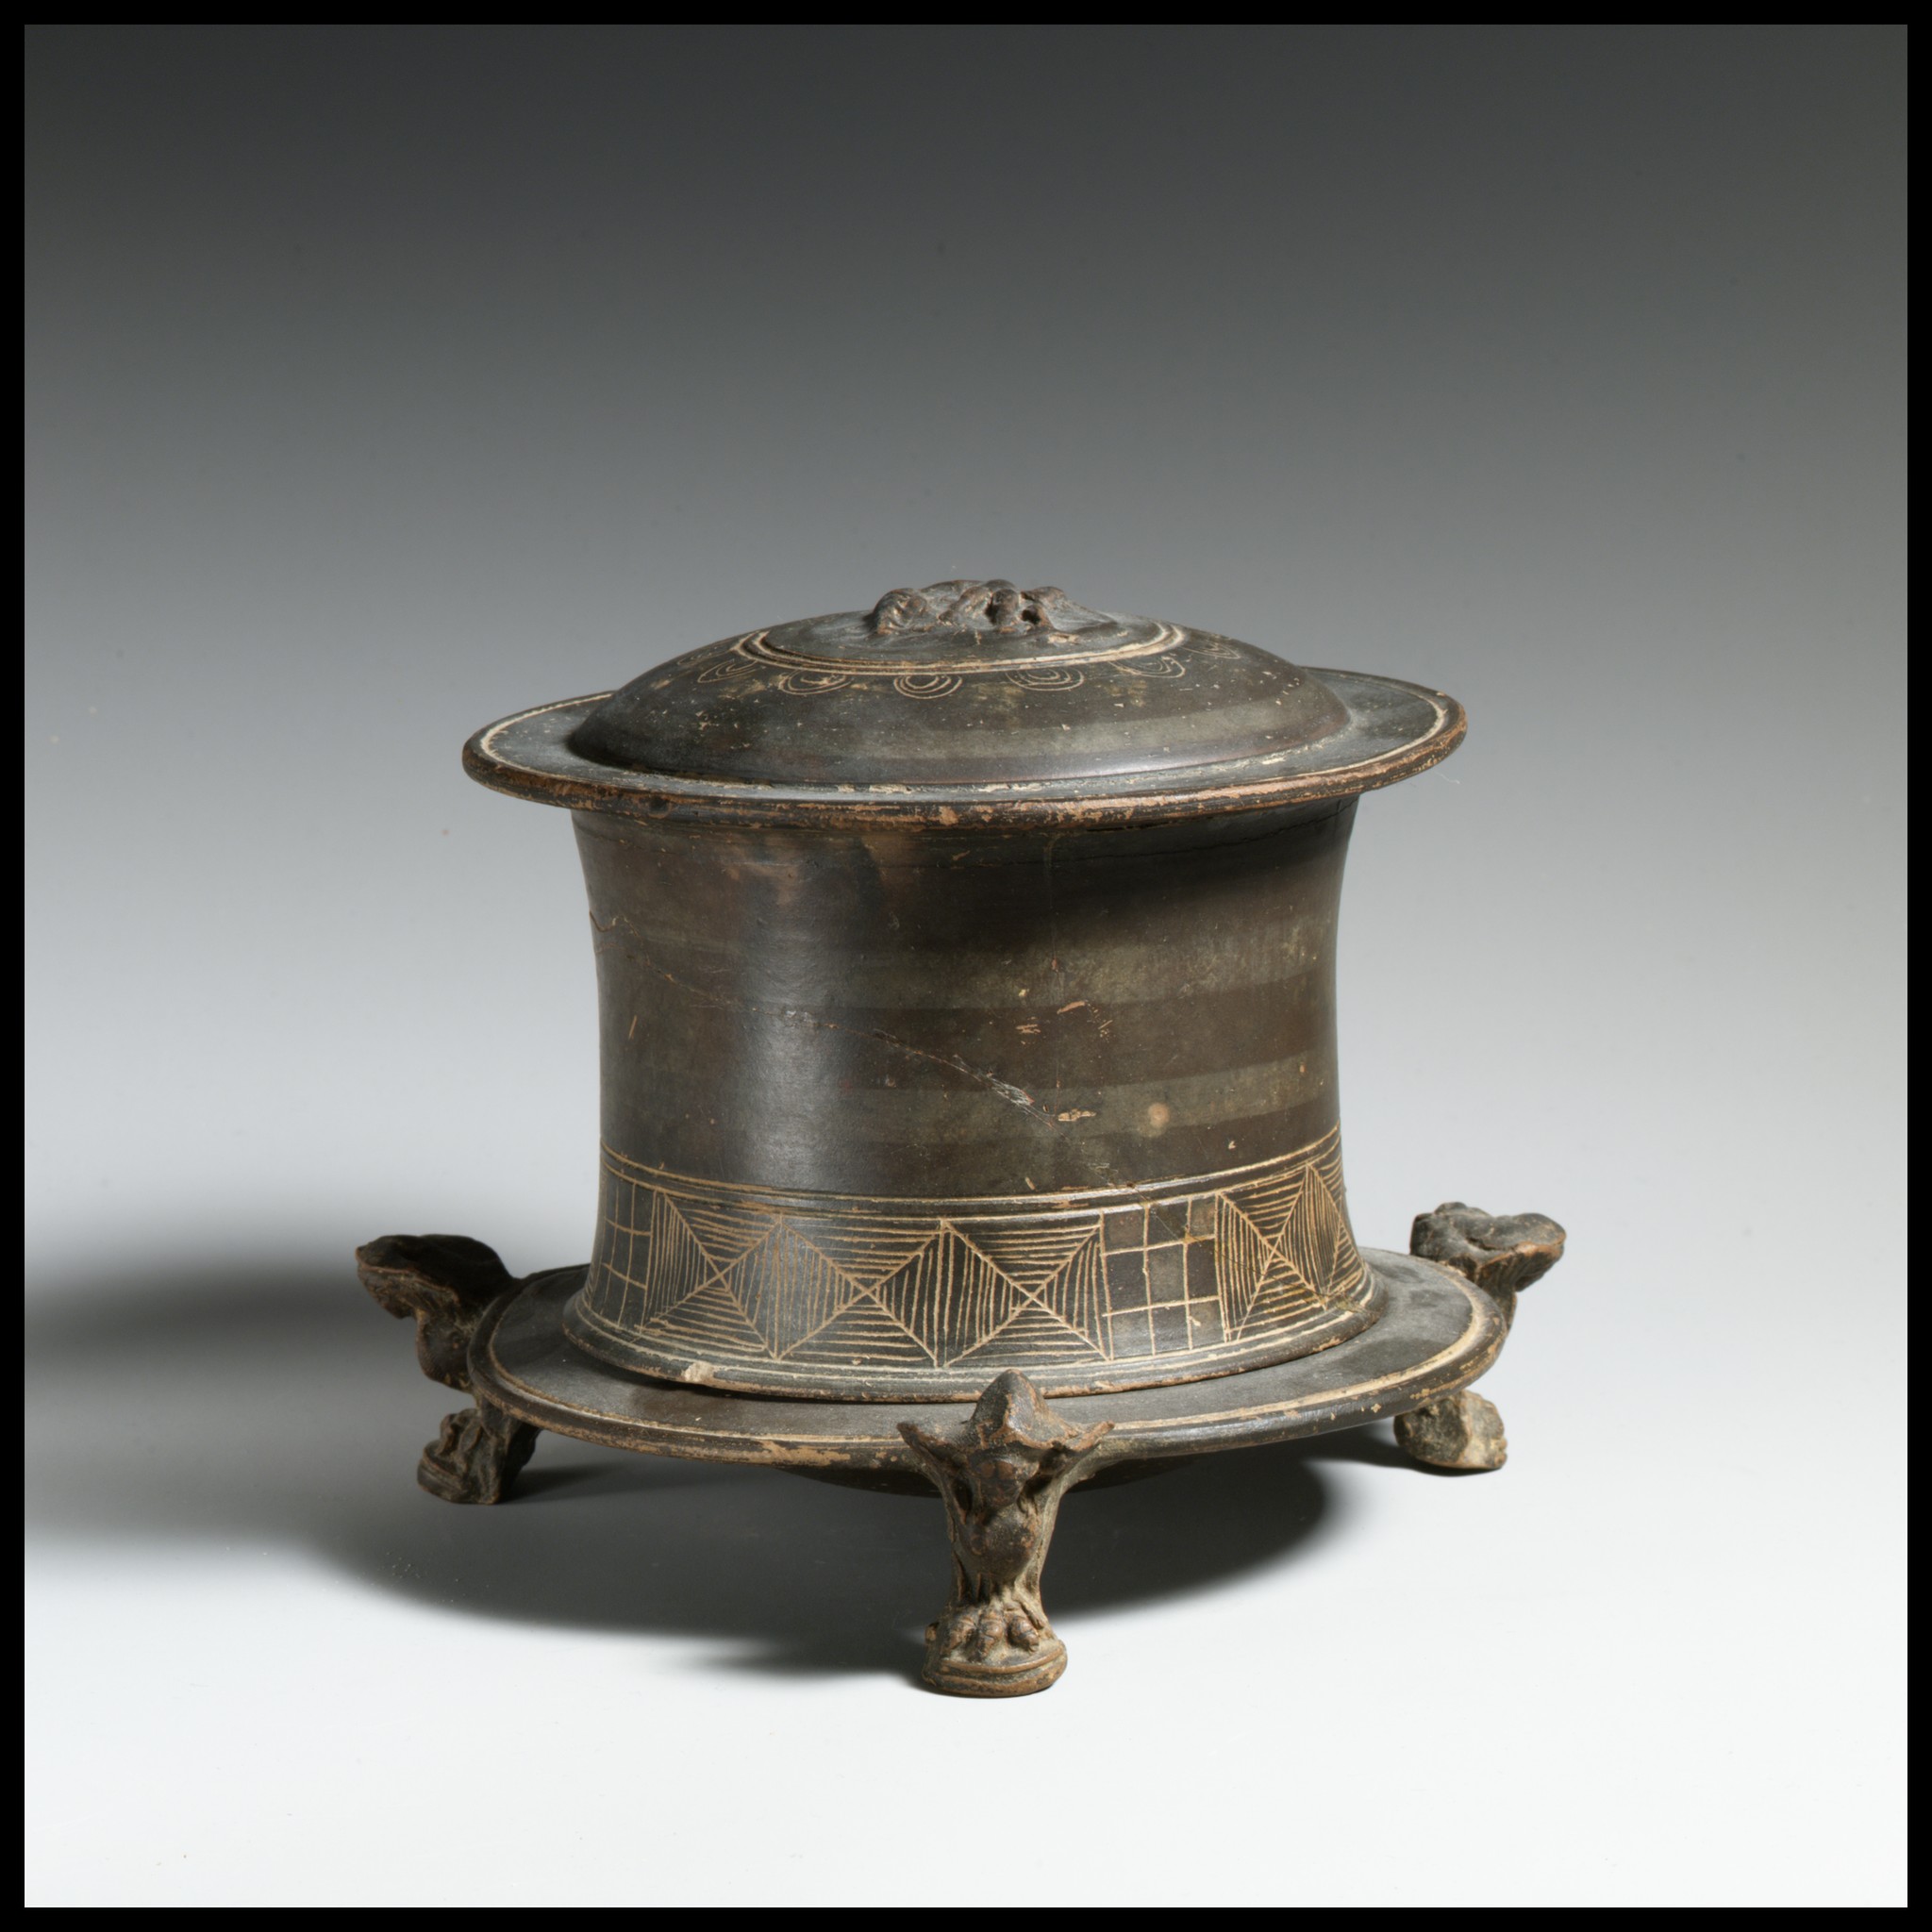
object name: pyxis with lid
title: Terracotta pyxis (cosmetic box)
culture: greek, macedonian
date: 300-101 BCE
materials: terracotta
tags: dionysus